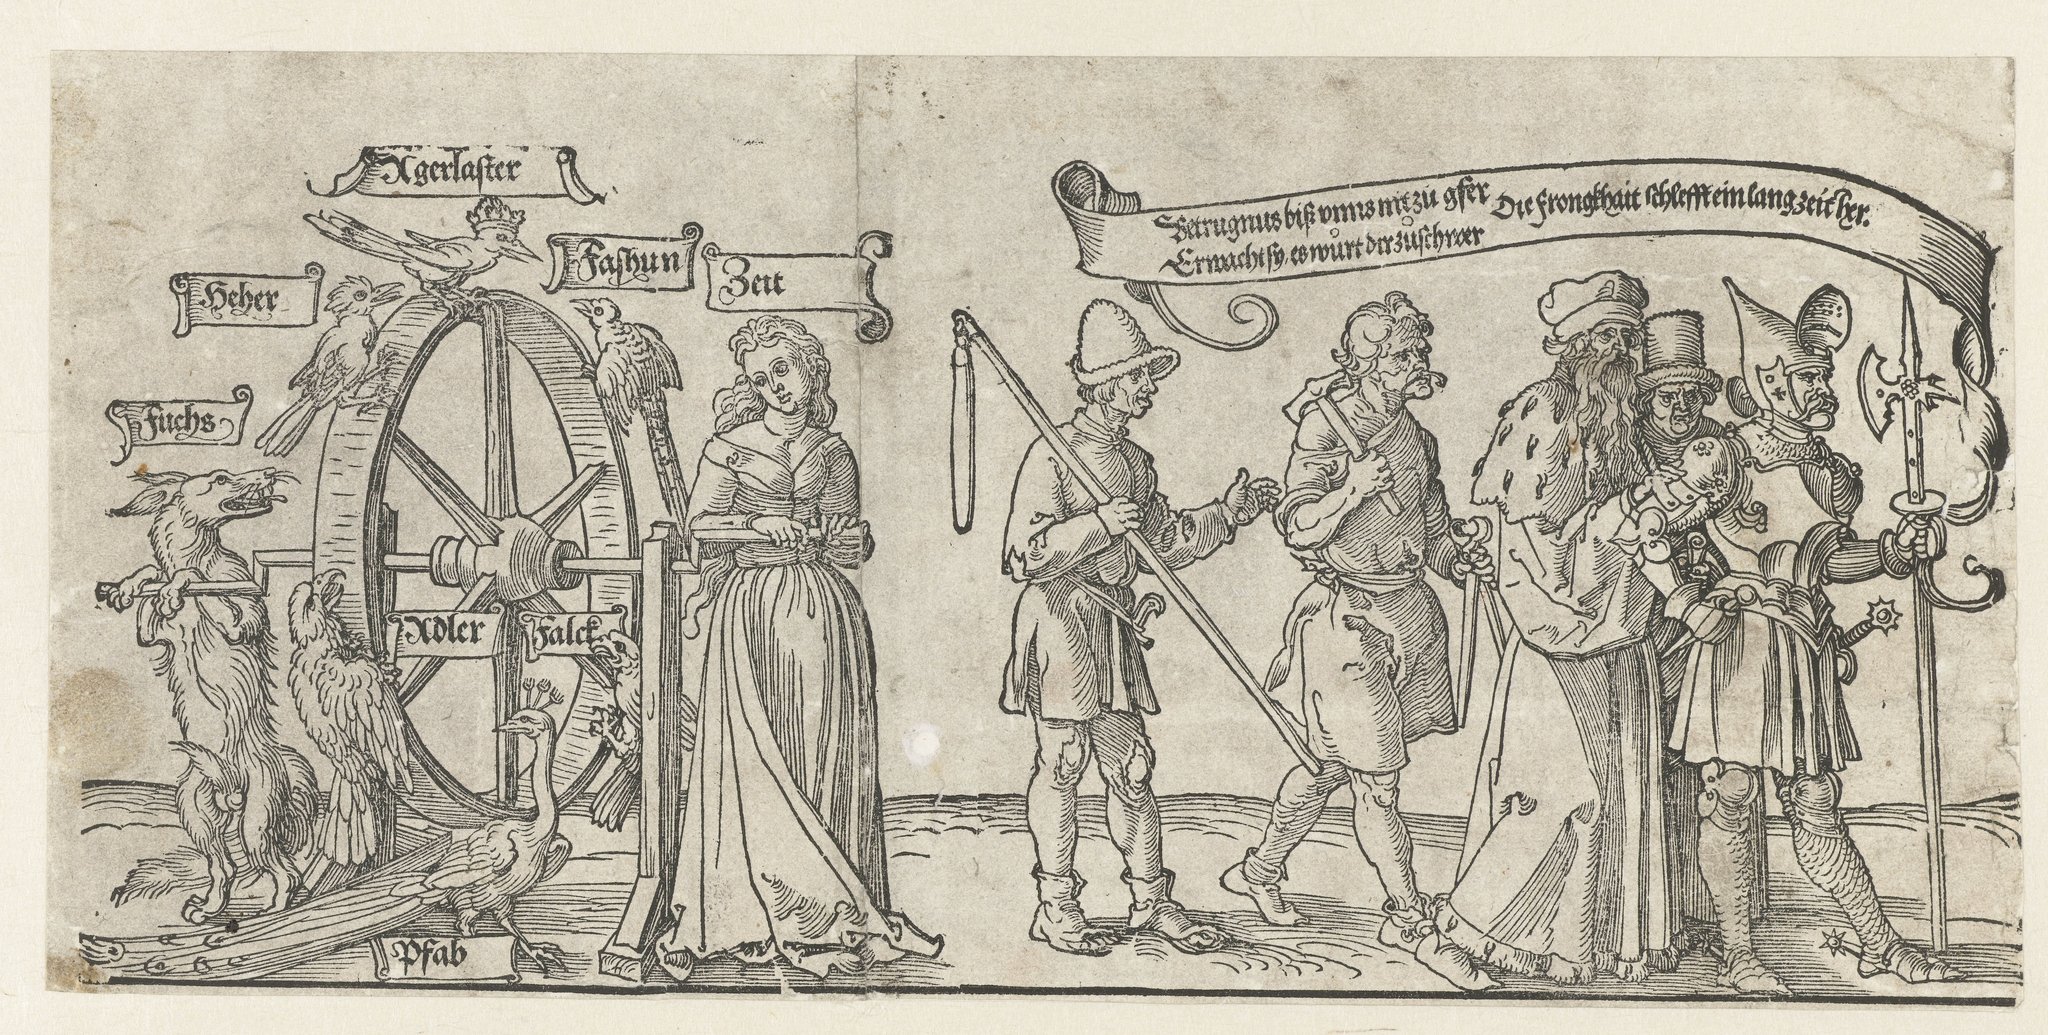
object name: print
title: Wandtapijt van Michelfeld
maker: albrecht dürer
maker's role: draughtsman, painter, print maker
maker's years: 1471-1528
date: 1521-1528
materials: paper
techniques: woodcut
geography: nuremberg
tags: farmers, contrast between rich and poor, contrast between important and unimportant people; the inferior before the superior, the weak before the mighty, working class, labourers, social stratification, social groups, turn of fate, wheel of fortune, nobility and patriciate; chivalry, knighthood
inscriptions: collector's mark: Lugt 2228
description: Het linkerdeel (de eerste twee blokken van de zes) van een brede houtsnede, die ofwel het voorbeeld is geweest voor, ofwel een kopie is van de voorstelling op een wandtapijt uit Slot Michelfeld aan de Rijn. Links het rad van fortuin, bewogen door enerzijds een vos en anderzijds een jongedame die Tijd verbeeldt. Rechts een boer, een smid, een koopman, een vorst en een ridder, verbeeldingen van de vijf sociale standen. Zij voeren een banderol mee met daarop een tekst over de onrechtvaardige rechter op het volgende deel van de houtsnede.